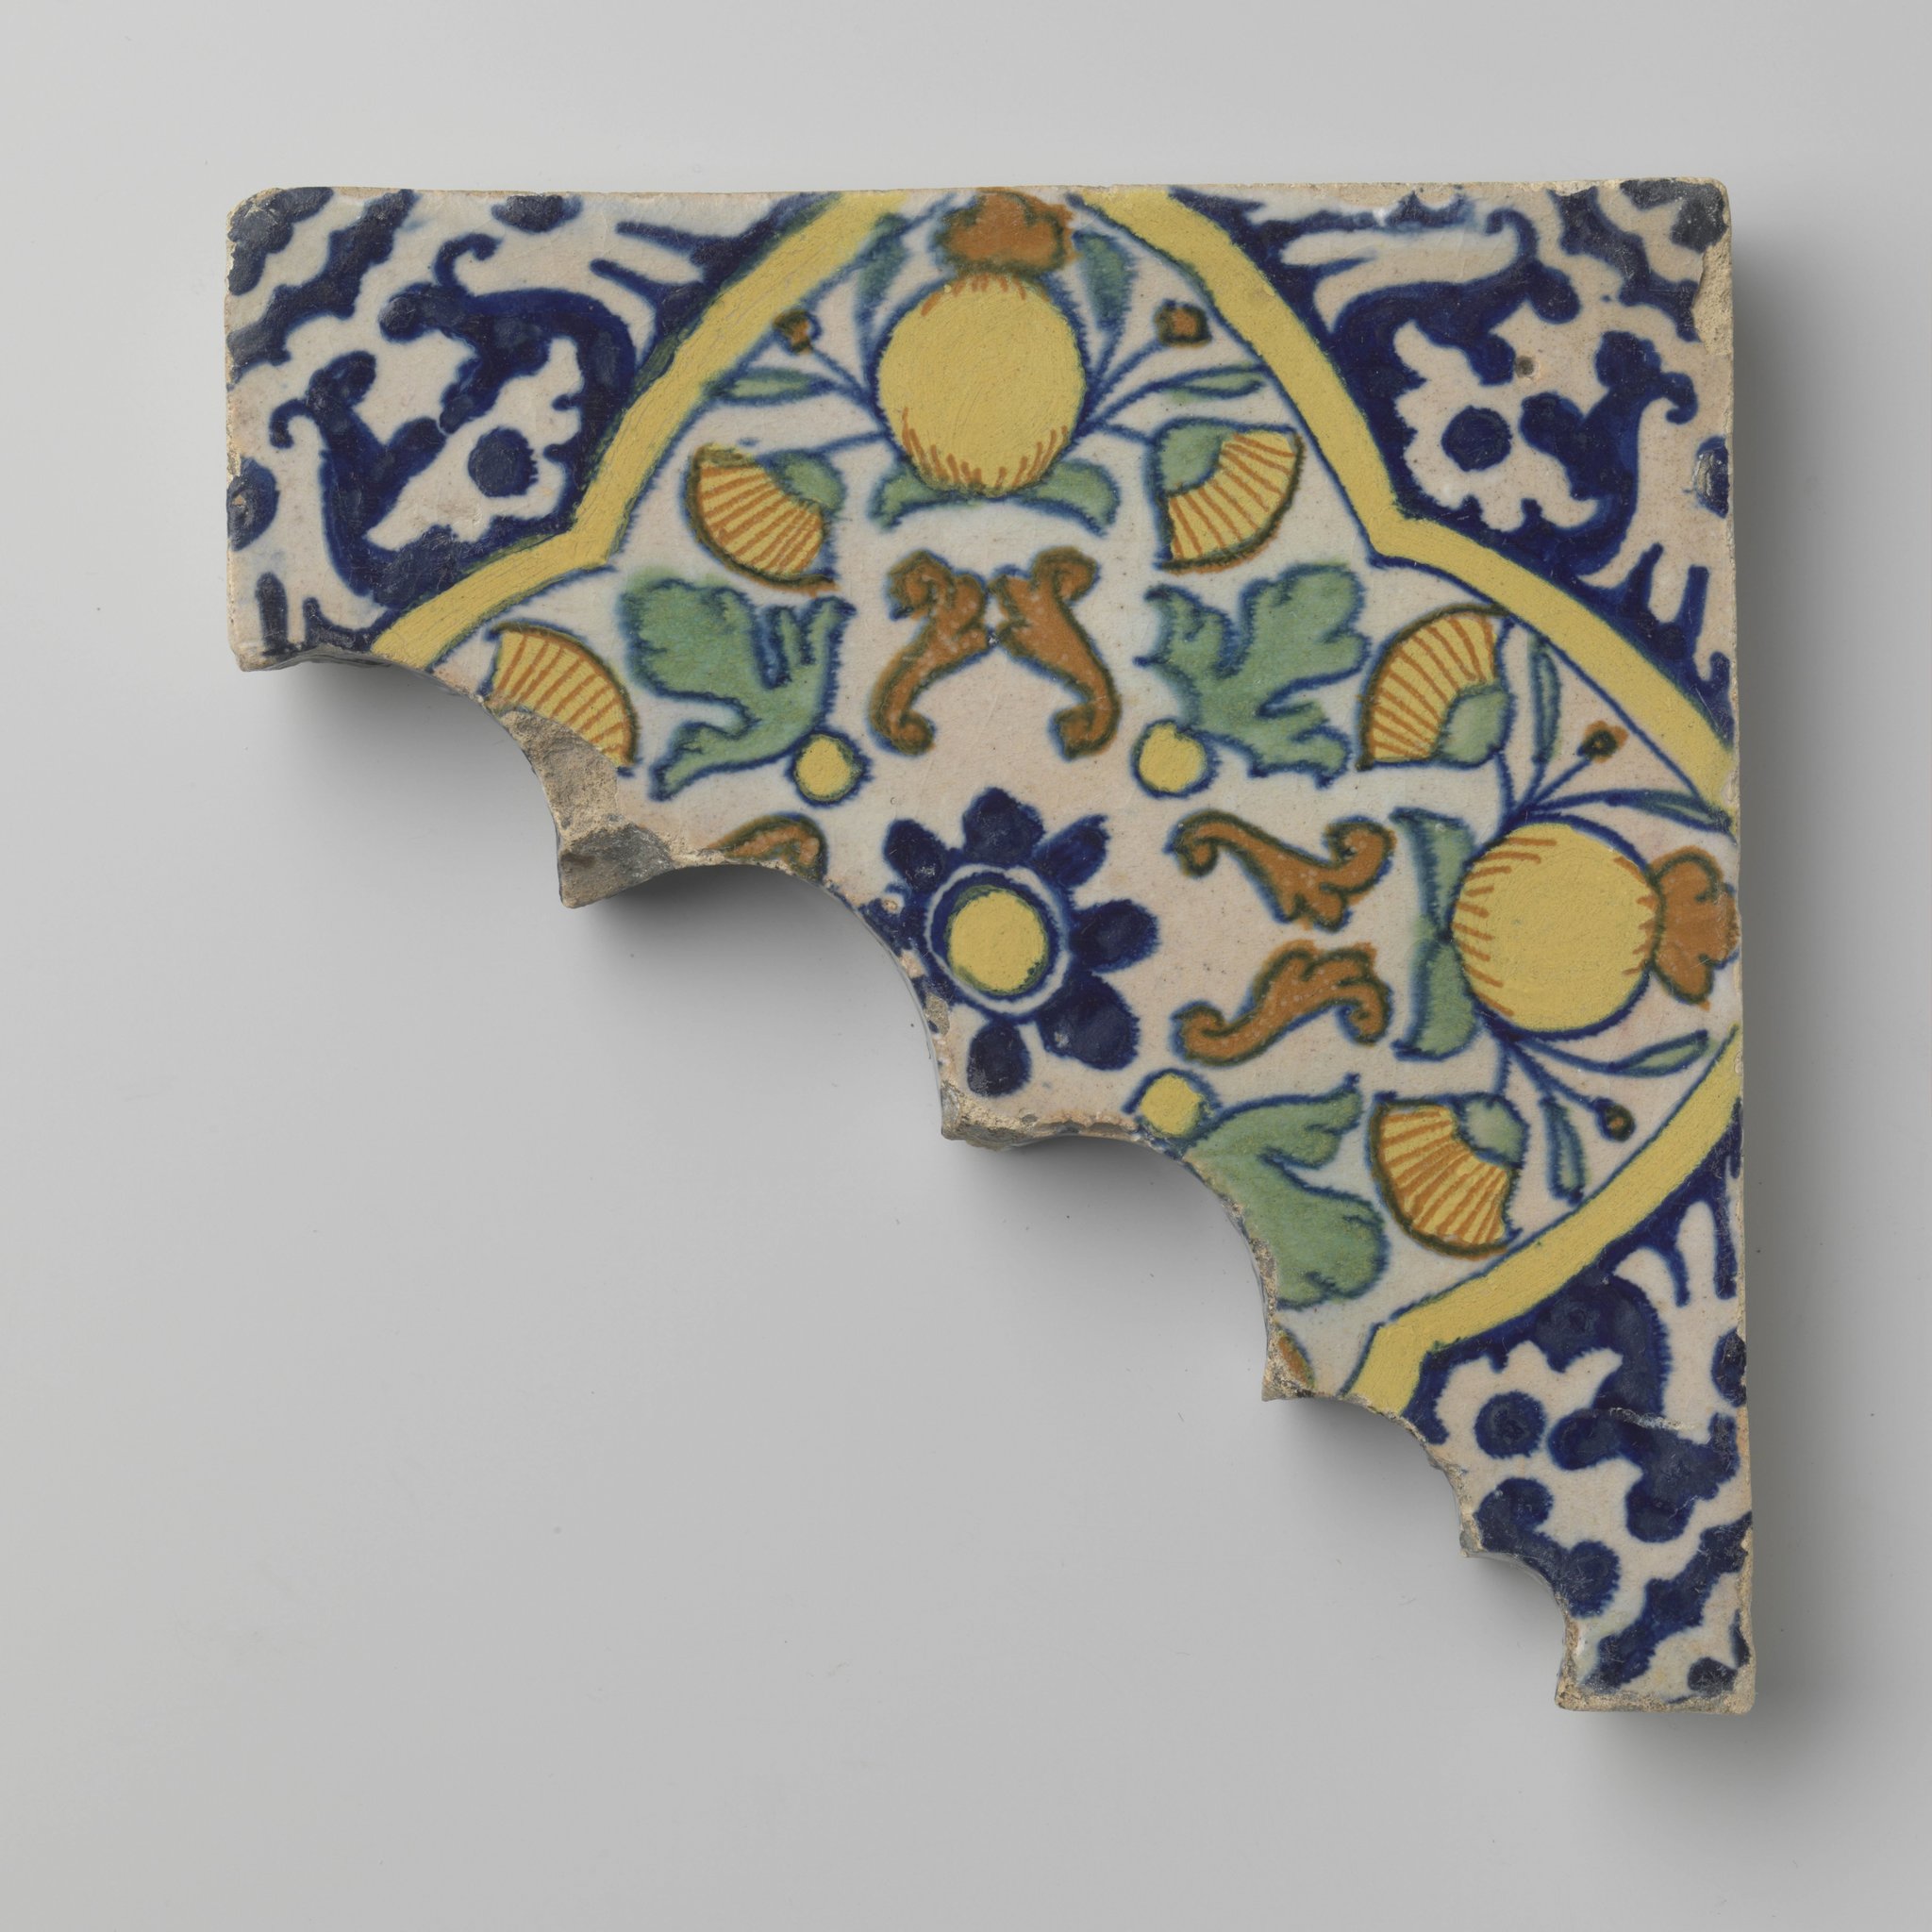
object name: nistegel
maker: Anonymous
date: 1615-1635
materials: earthenware, glaze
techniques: maiolica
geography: netherlands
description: Nistegel met geschulpte lange zijde. De zijkant van deze lange zijde is versierd met ranken. De bovenkant van de tegel is versierd met een veelkleurige (blauw, groen, geel en oranjebruin) rozet omgeven door vruchten en bloemen, binnen een vierpas omlijsting. In de hoeken, vultechniek ornament.